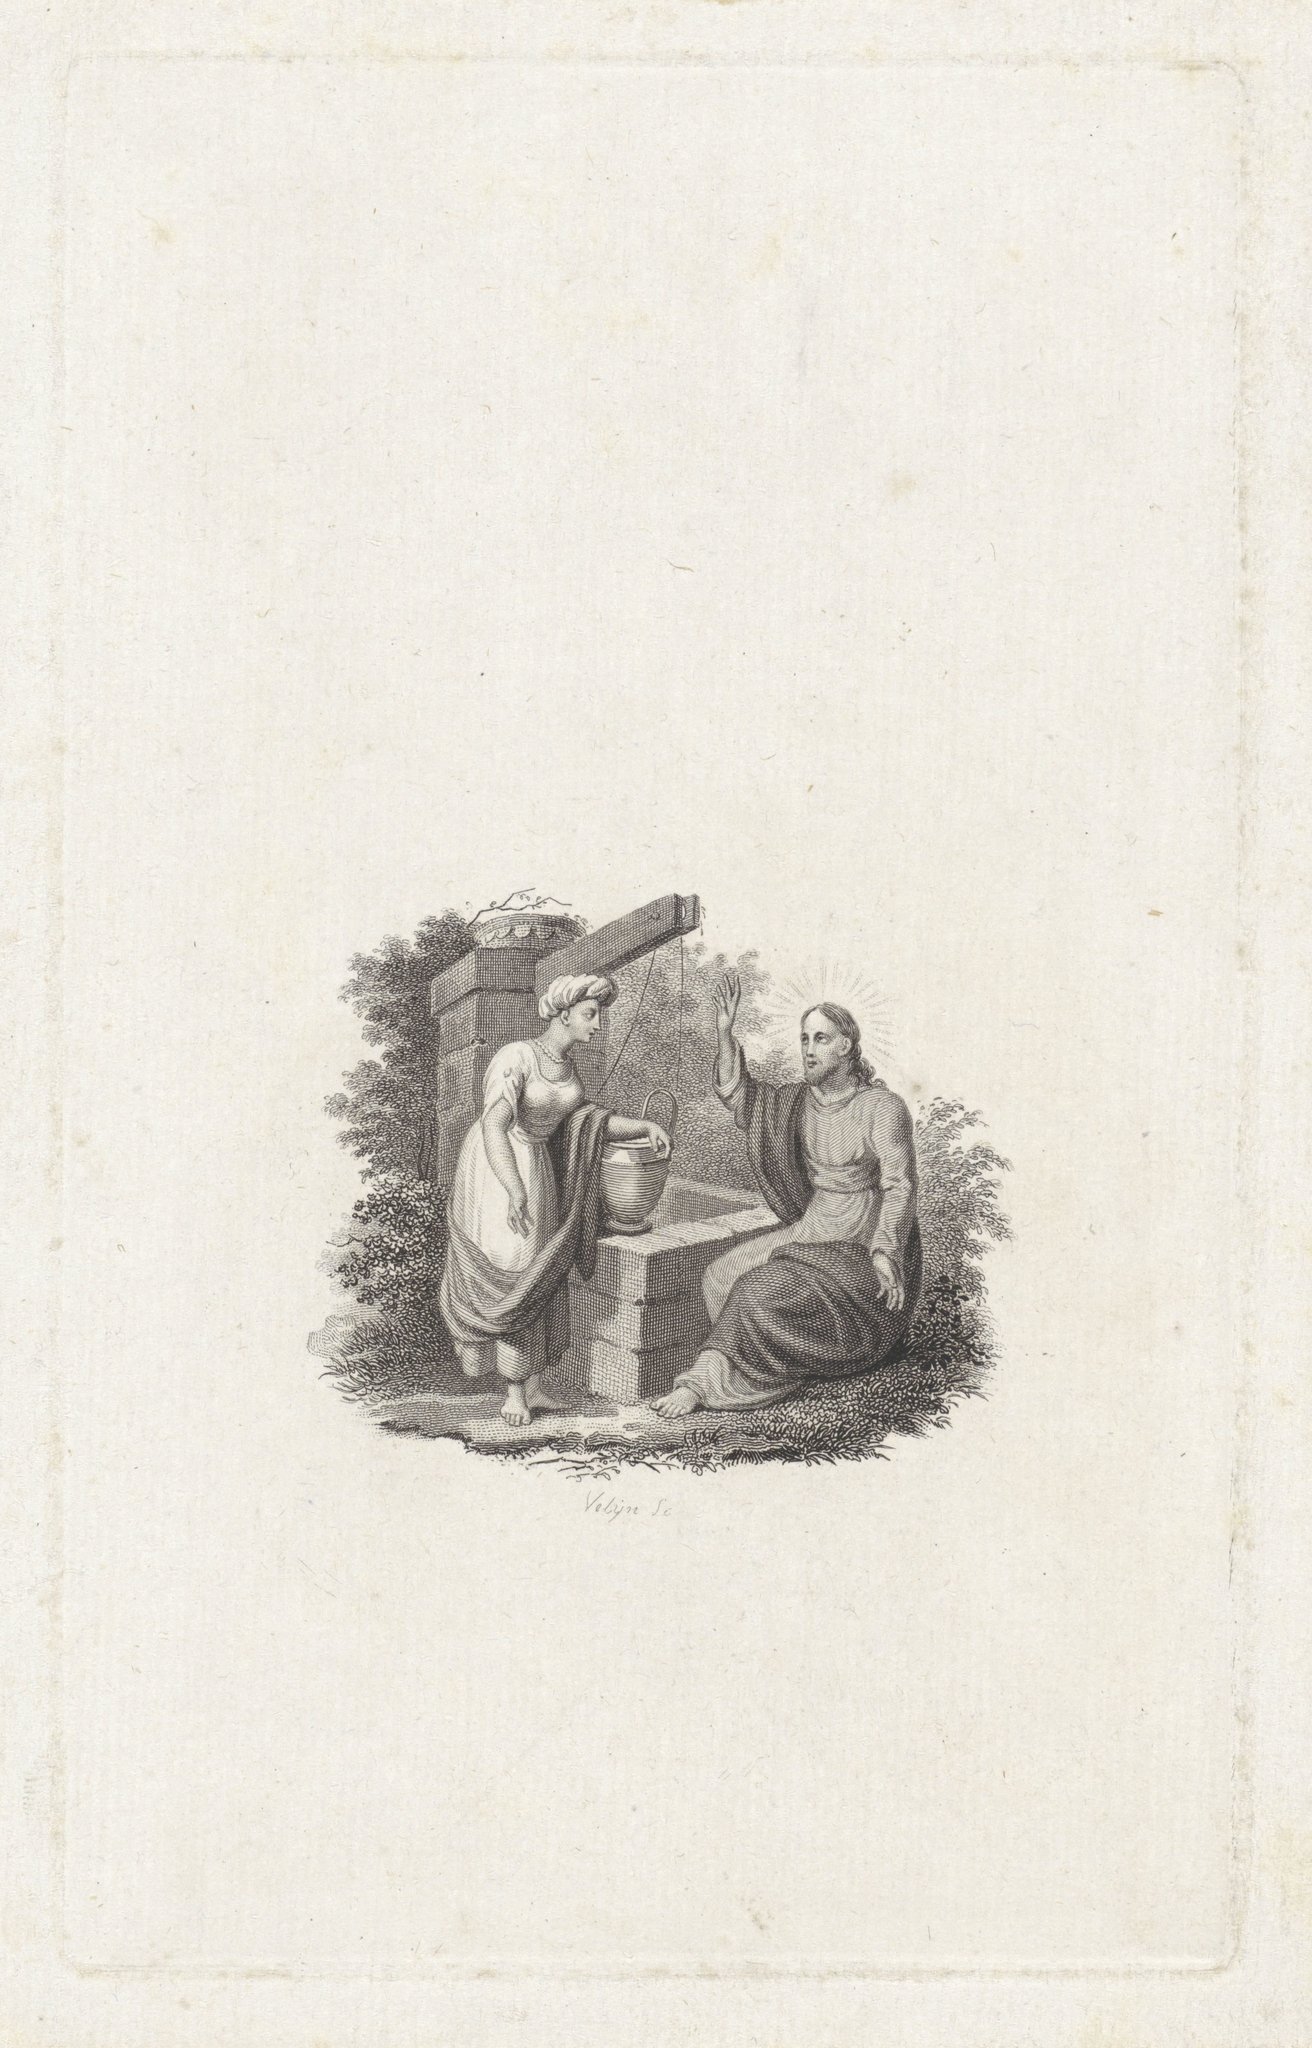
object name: print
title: Christus in gesprek met de Samaritaanse vrouw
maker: philippus velijn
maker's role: print maker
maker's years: 1787-1836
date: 1797-1836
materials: paper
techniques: etching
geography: netherlands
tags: christ and the woman of samaria: sitting at jacob's well he asks her for a drink from her jug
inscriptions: collector's mark: Lugt 2228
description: Christus vraagt de Samaritaanse vrouw die water komt putten om hem iets te drinken te geven (Joh. 4: 7).